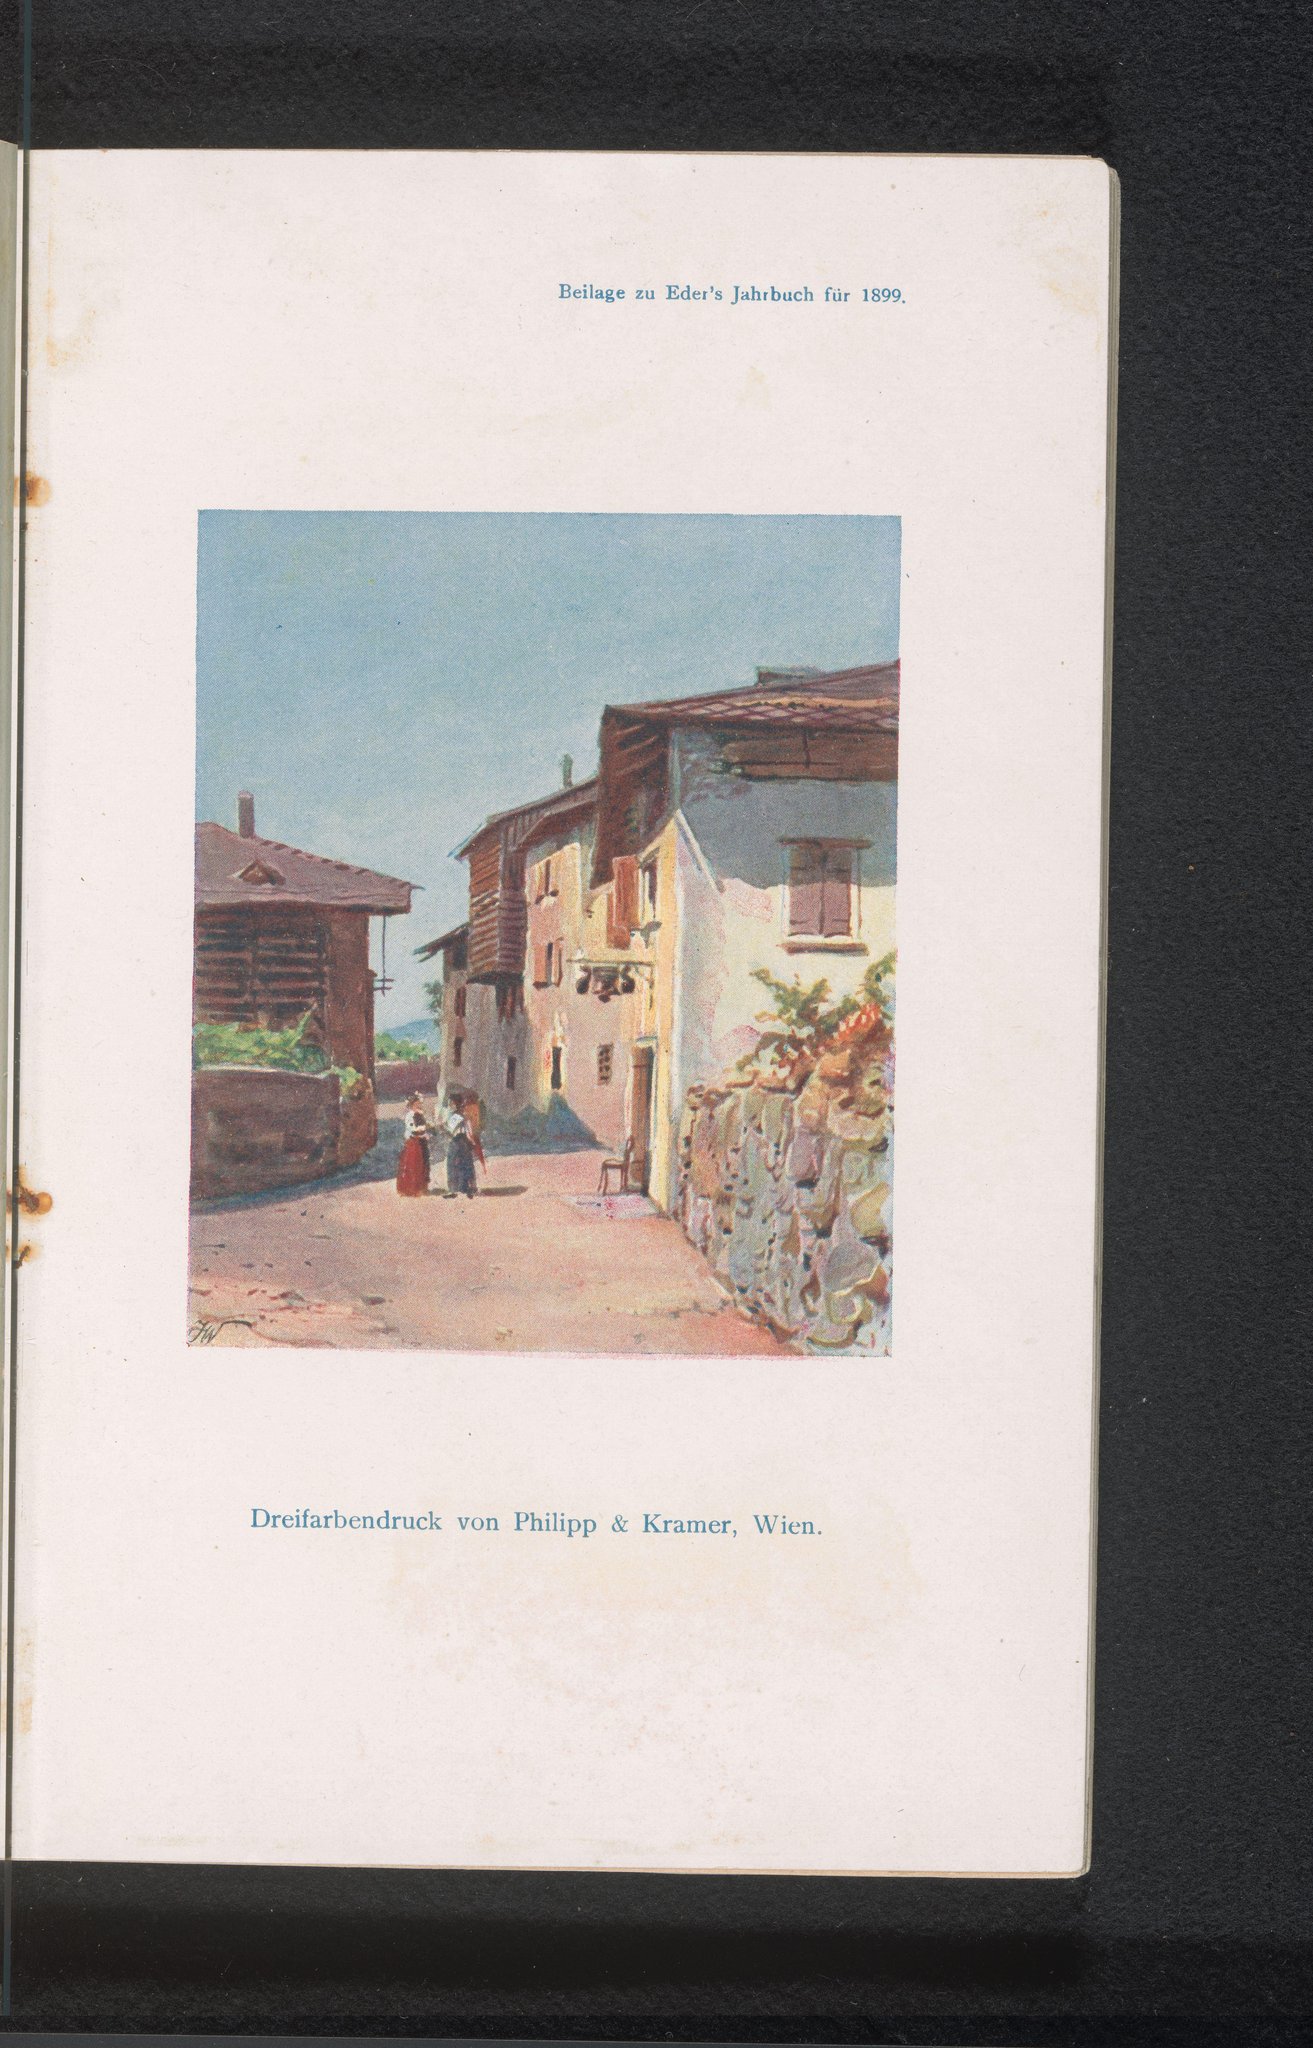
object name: photomechanical print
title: Reproductie van een ontwerp met de voorstelling van twee vrouwen op straat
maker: Anonymous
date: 1894-1899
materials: paper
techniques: three-color autotype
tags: adult woman, historical persons, street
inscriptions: inscription: ‘Beilage zu Eders Jahrbuch für 1899’